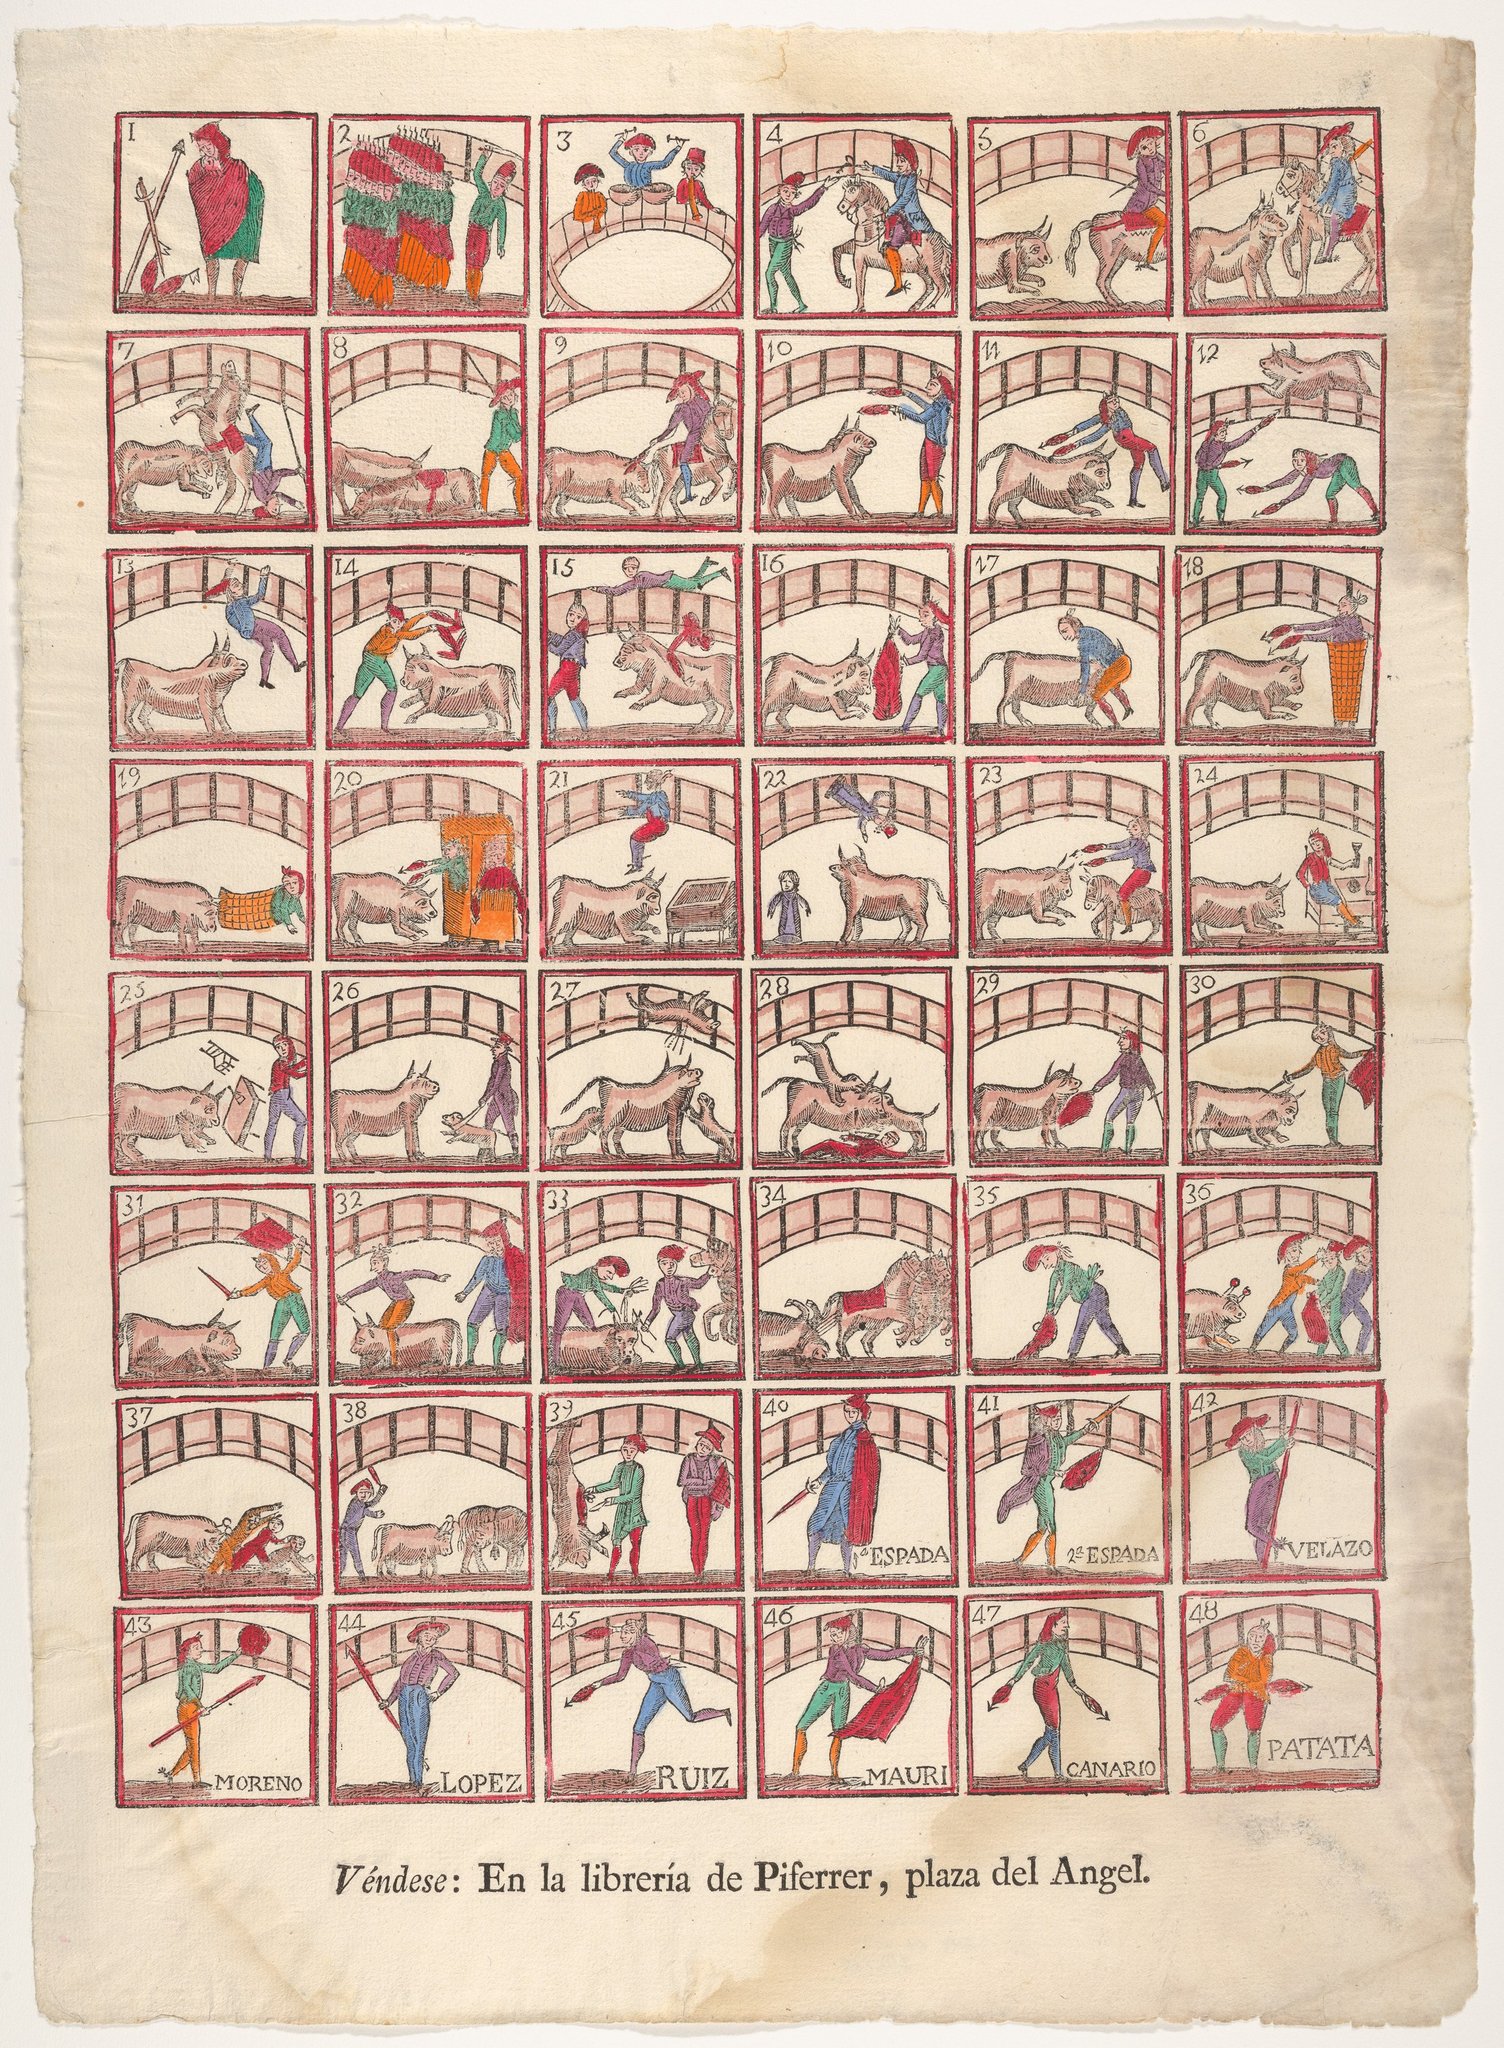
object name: print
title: Forty-eight vignettes of bullfighting manoeuvers and scenes from the ring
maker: Anonymous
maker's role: artist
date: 1800-1850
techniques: woodcut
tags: men,sports,bulls